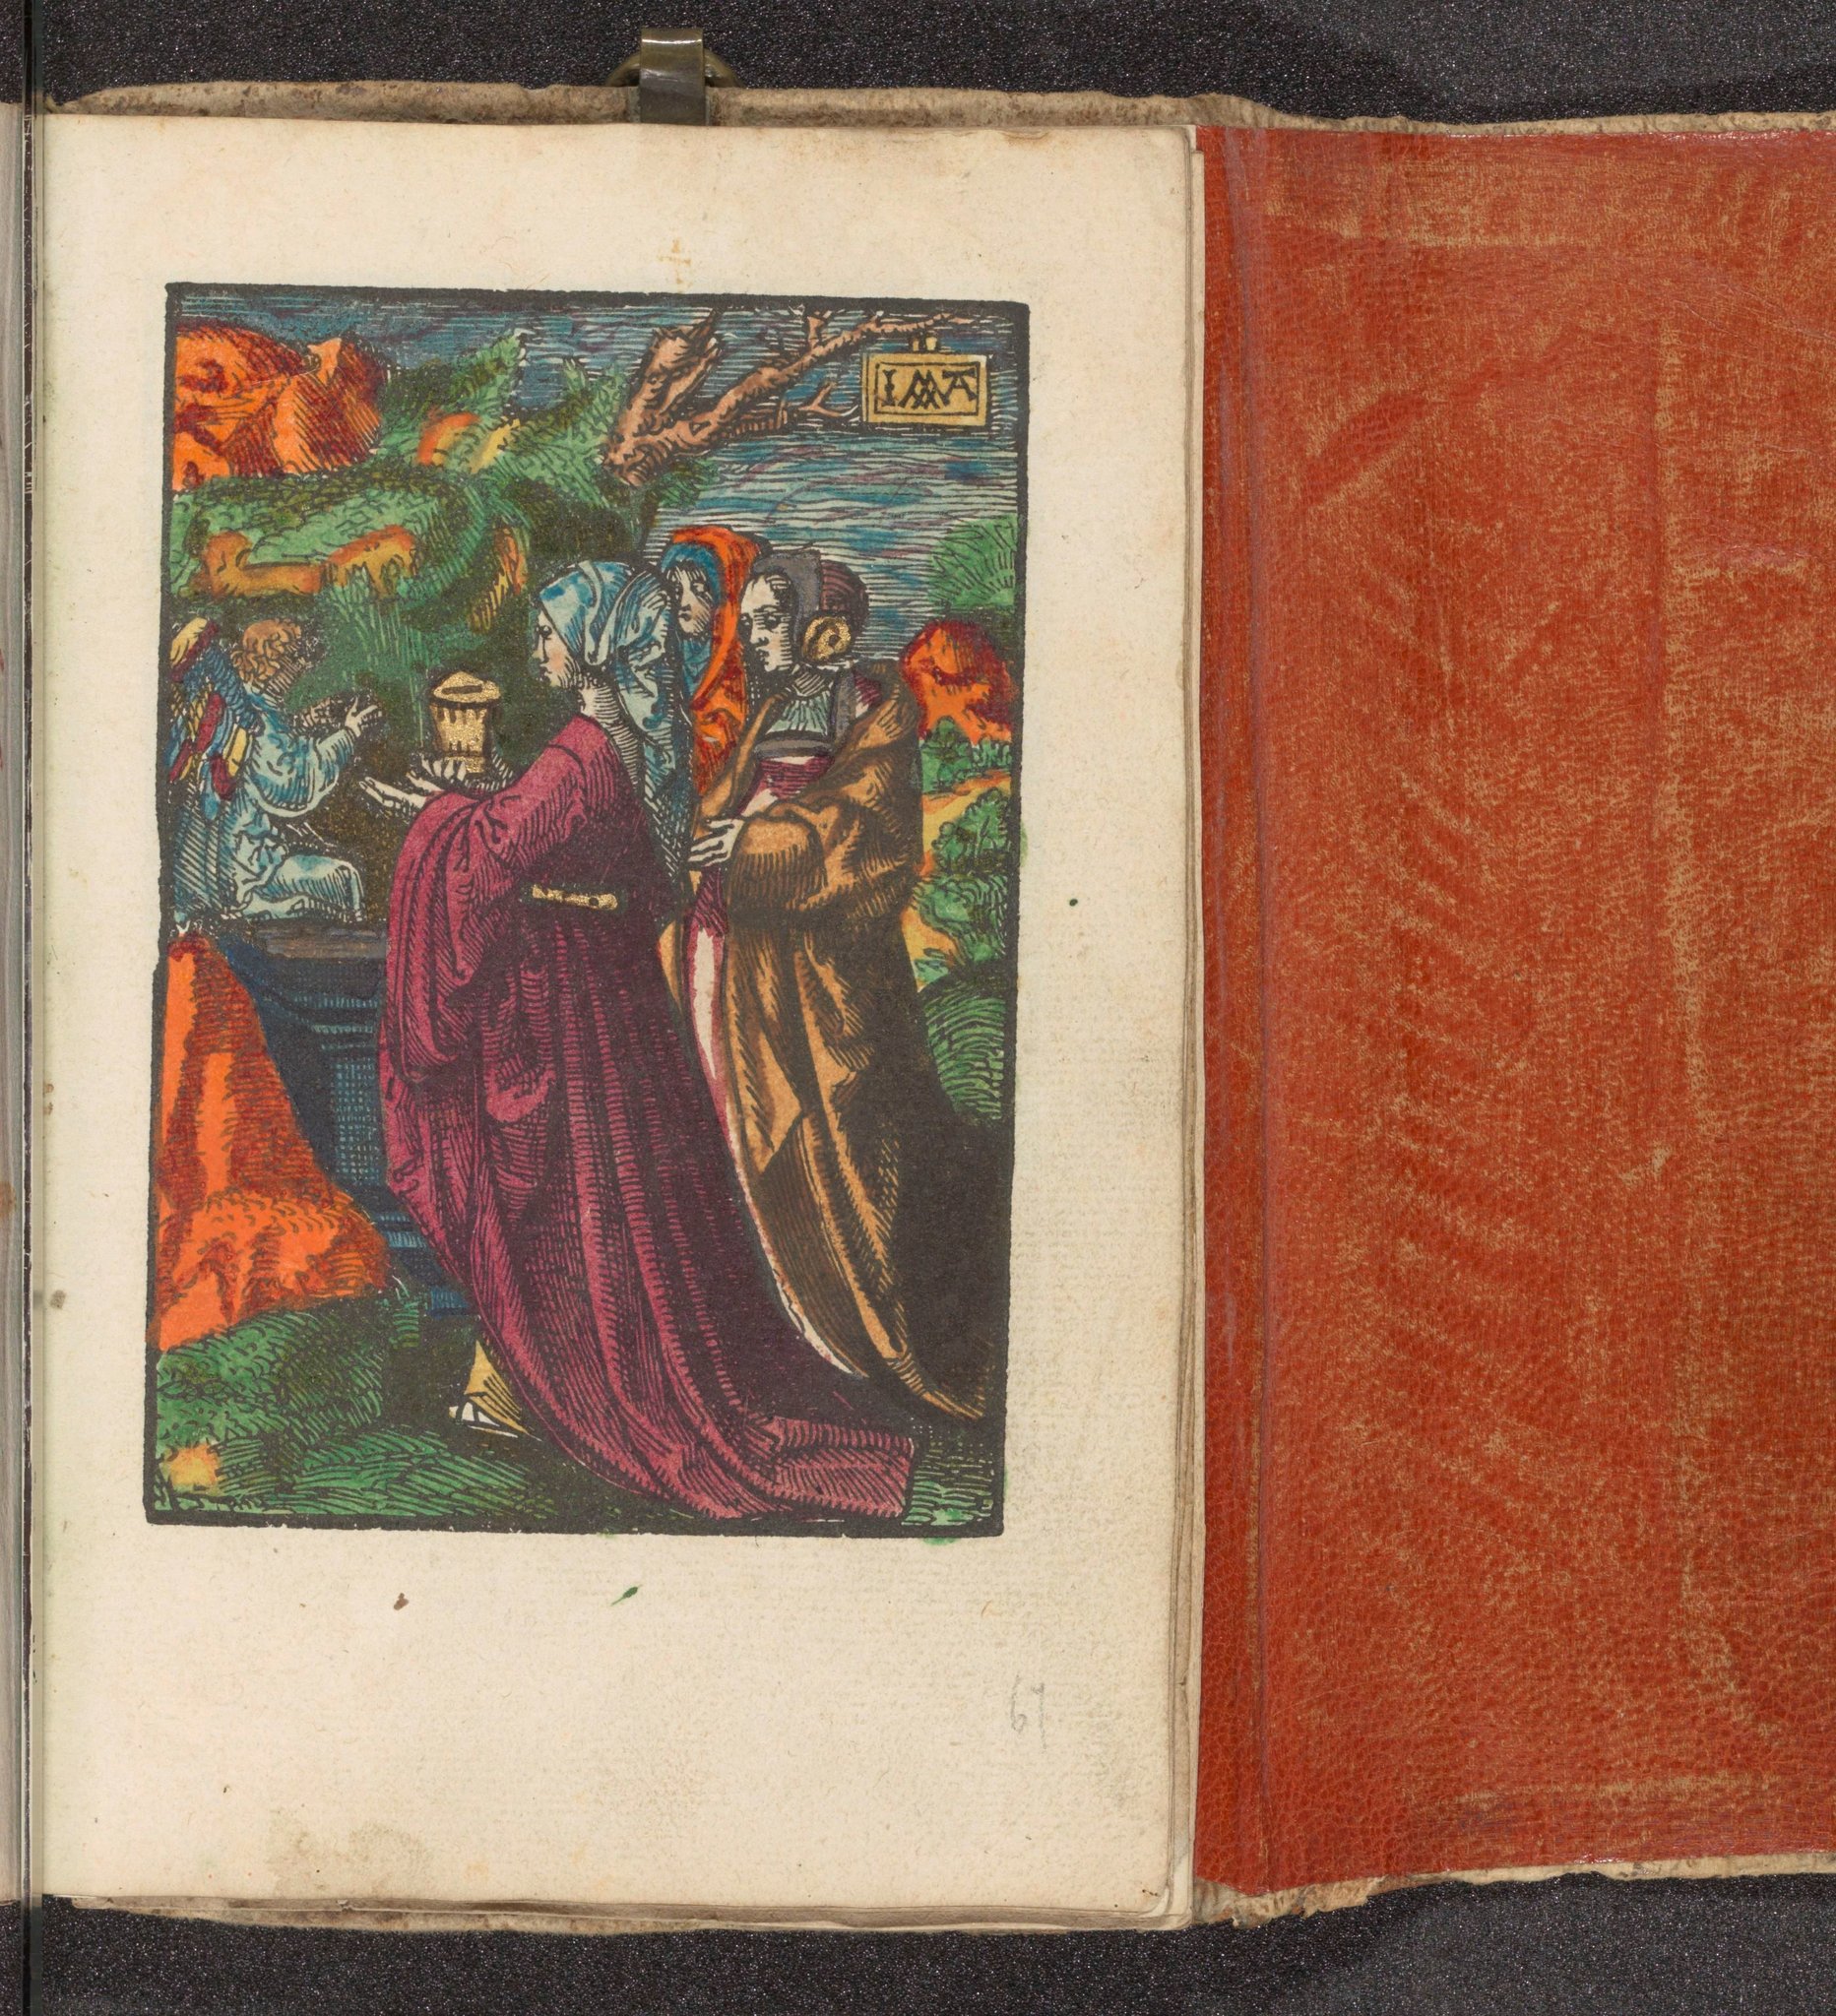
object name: album leaf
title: De kleine Passie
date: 1520-1521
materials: paper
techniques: hand coloring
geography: amsterdam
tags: the holy women (the three maries) on their way to or at the tomb, to anoint christ's body, book in which illustrations are essential, angel(s) addressing the holy women ~ resurrection of christ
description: De drie heilige vrouwen of Maria's komen bij het graf van Christus om zijn lichaam te verzorgen. Het graf is leeg en ze ontmoeten een engel die hen vertelt dat Christus is opgestaan. Prent maakt deel uit van een boek.